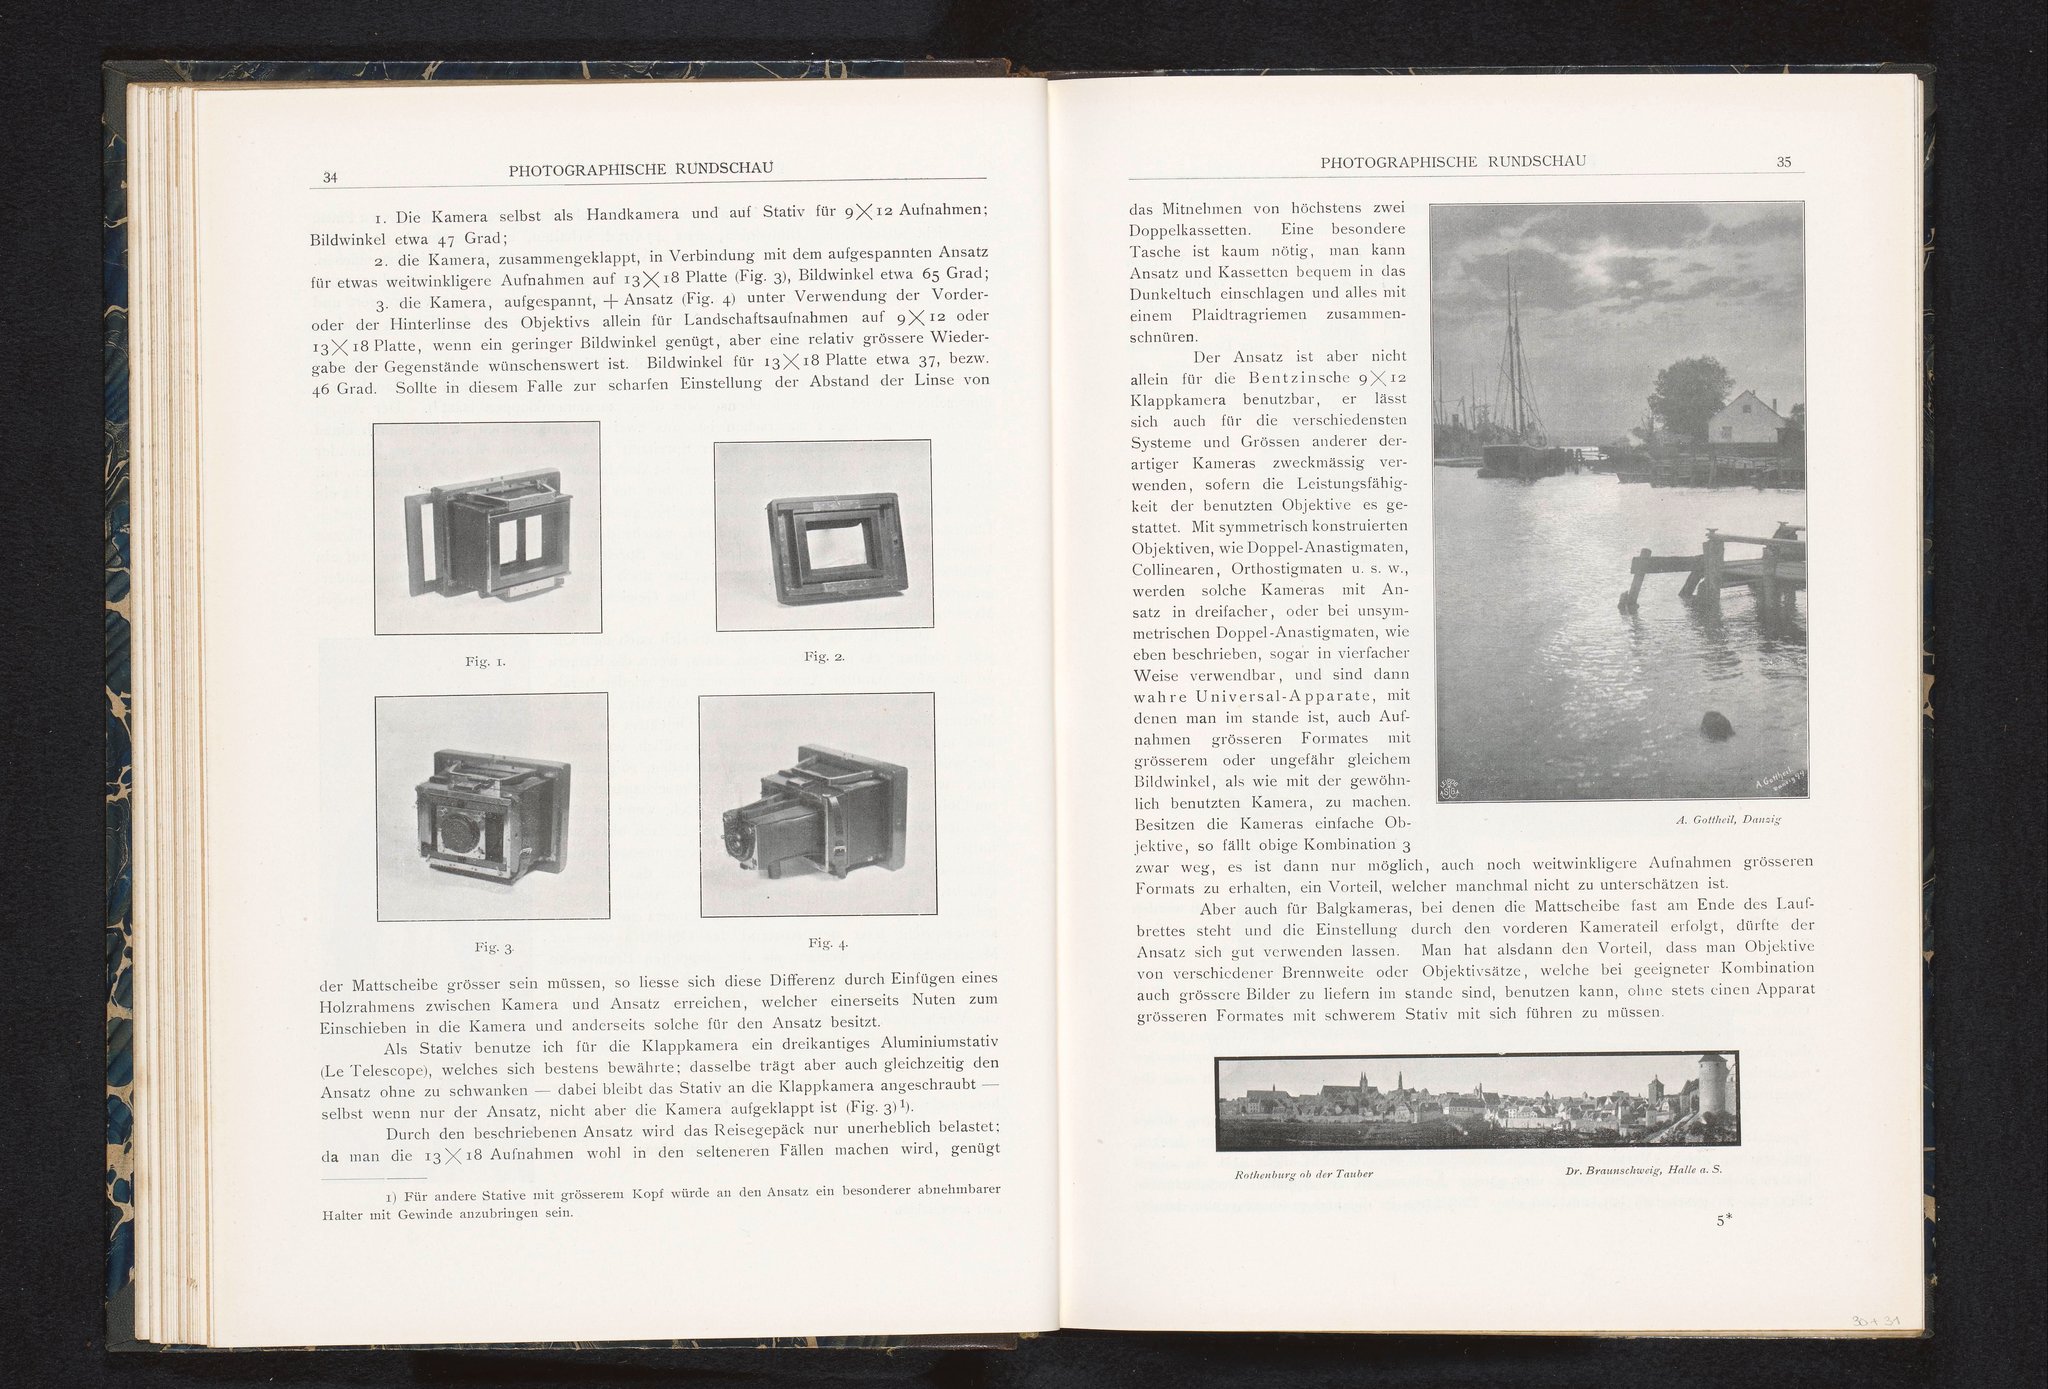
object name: page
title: Gezicht op Rothenburg ob der Tauber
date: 1896-1901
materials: paper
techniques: autotype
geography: rothenburg ob der tauber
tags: city-view, and landscape with man-made constructions